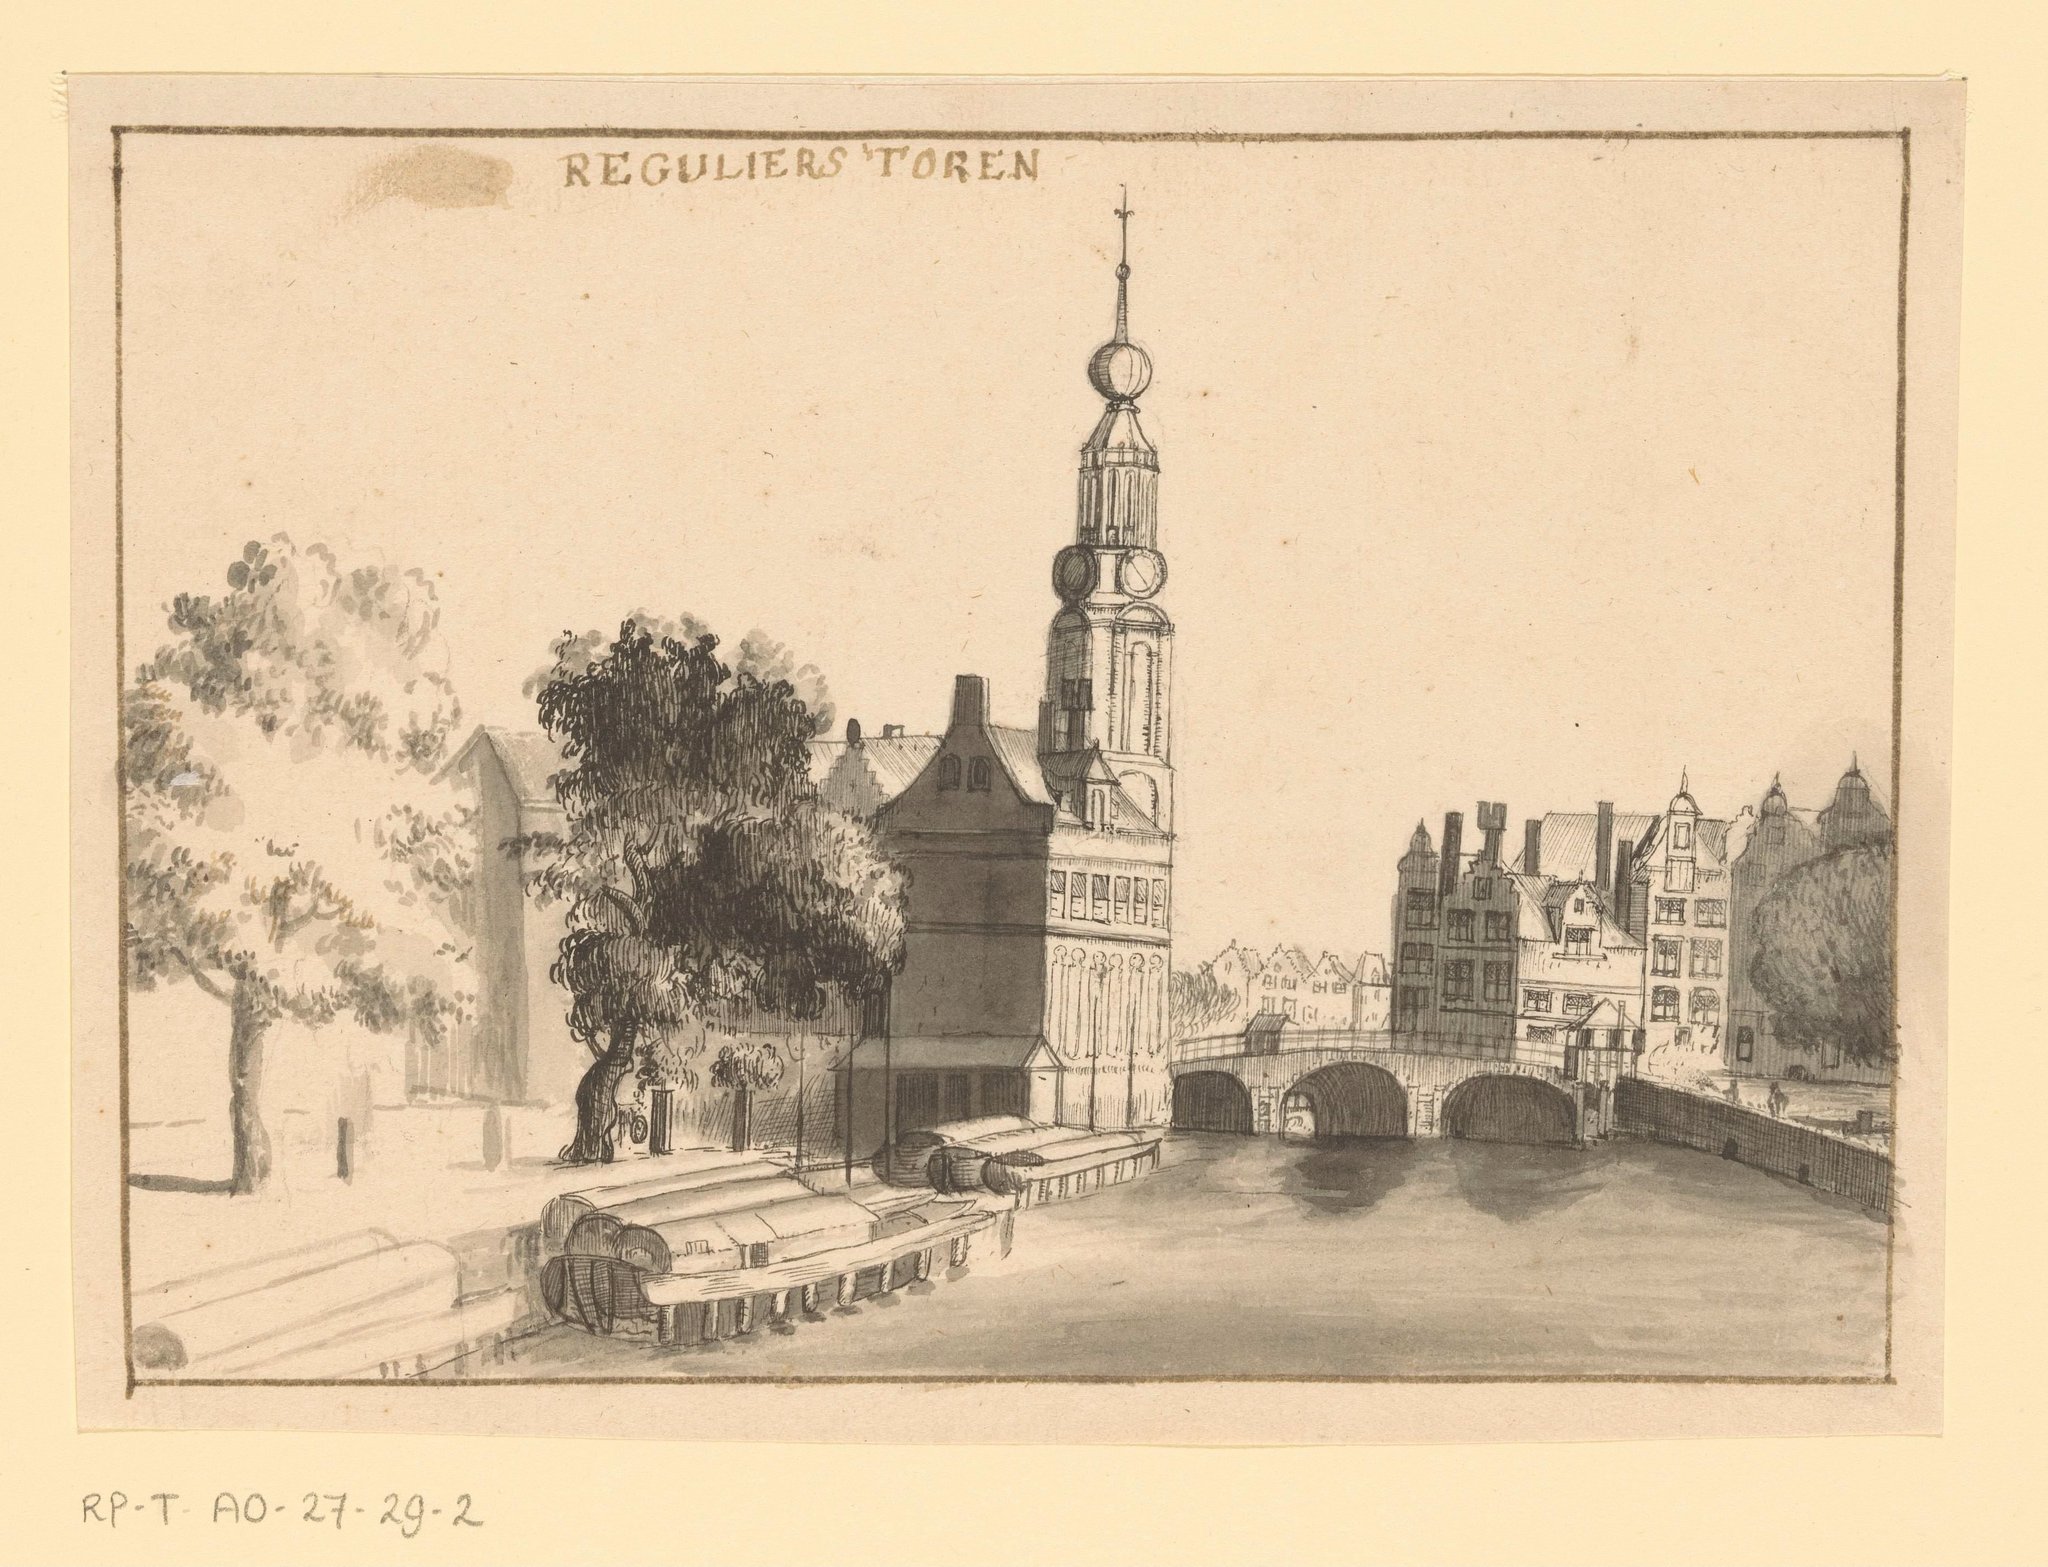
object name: drawing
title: Reguliers Toren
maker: Anonymous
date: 1650-1749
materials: ink, paper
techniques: brush, pen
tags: bridge in city across river, canal, etc. (+ city(-scape) with figures, staffage), tower, clock tower ~ monumental adornment, canals, waters (in city) (+ city(-scape) with figures, staffage), street (+ city(-scape) with figures, staffage)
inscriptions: collector's mark: Lugt 2228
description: Gezicht op de Munttoren, tot 1672 alleen bekend als de Regulierstoren, te Amsterdam. Gezien vanaf de Singel. Rechts van de toren de Muntsluis.